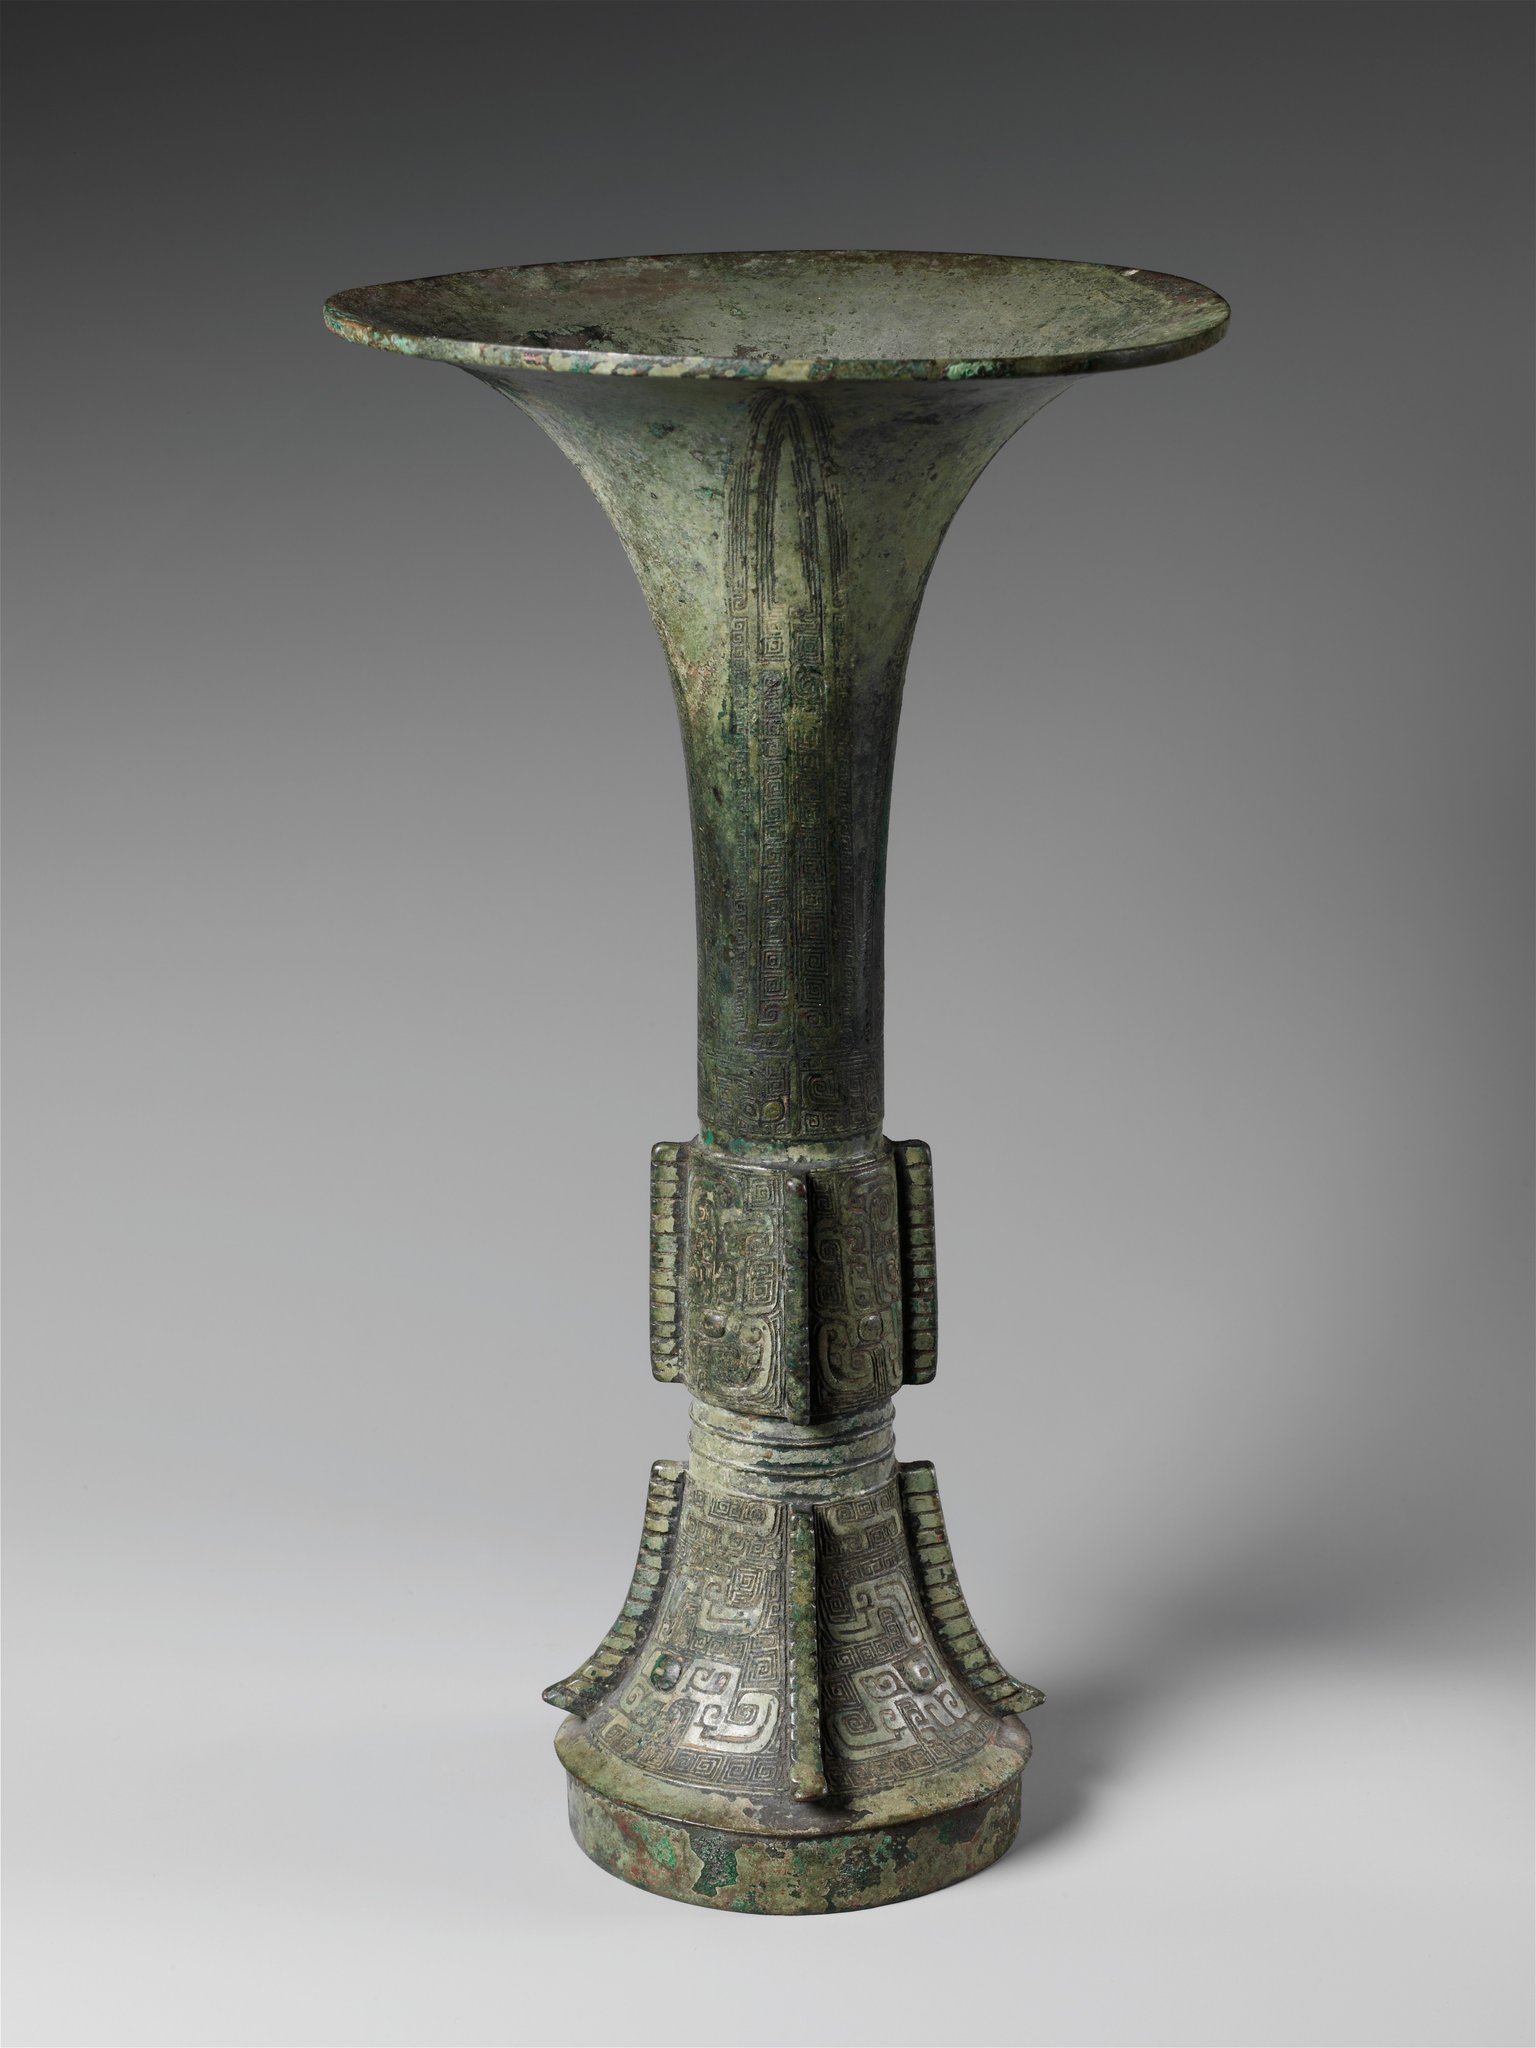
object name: wine beaker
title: Wine beaker (gu)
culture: chinese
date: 1300-1001 BCE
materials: bronze